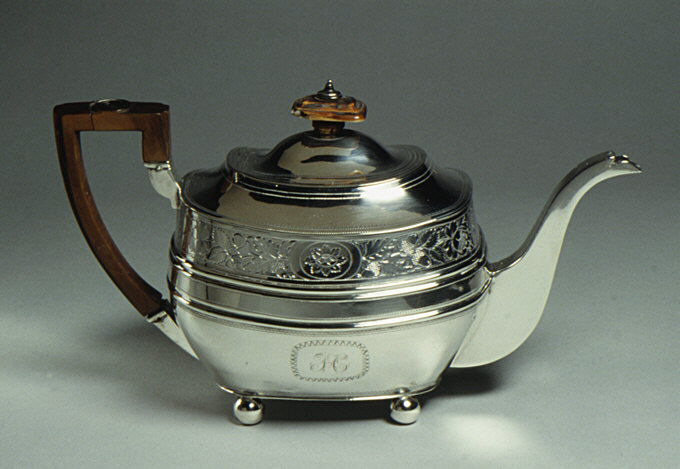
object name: teapot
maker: duncan urquhart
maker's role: maker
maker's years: 1791-1809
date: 1808-1809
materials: silver